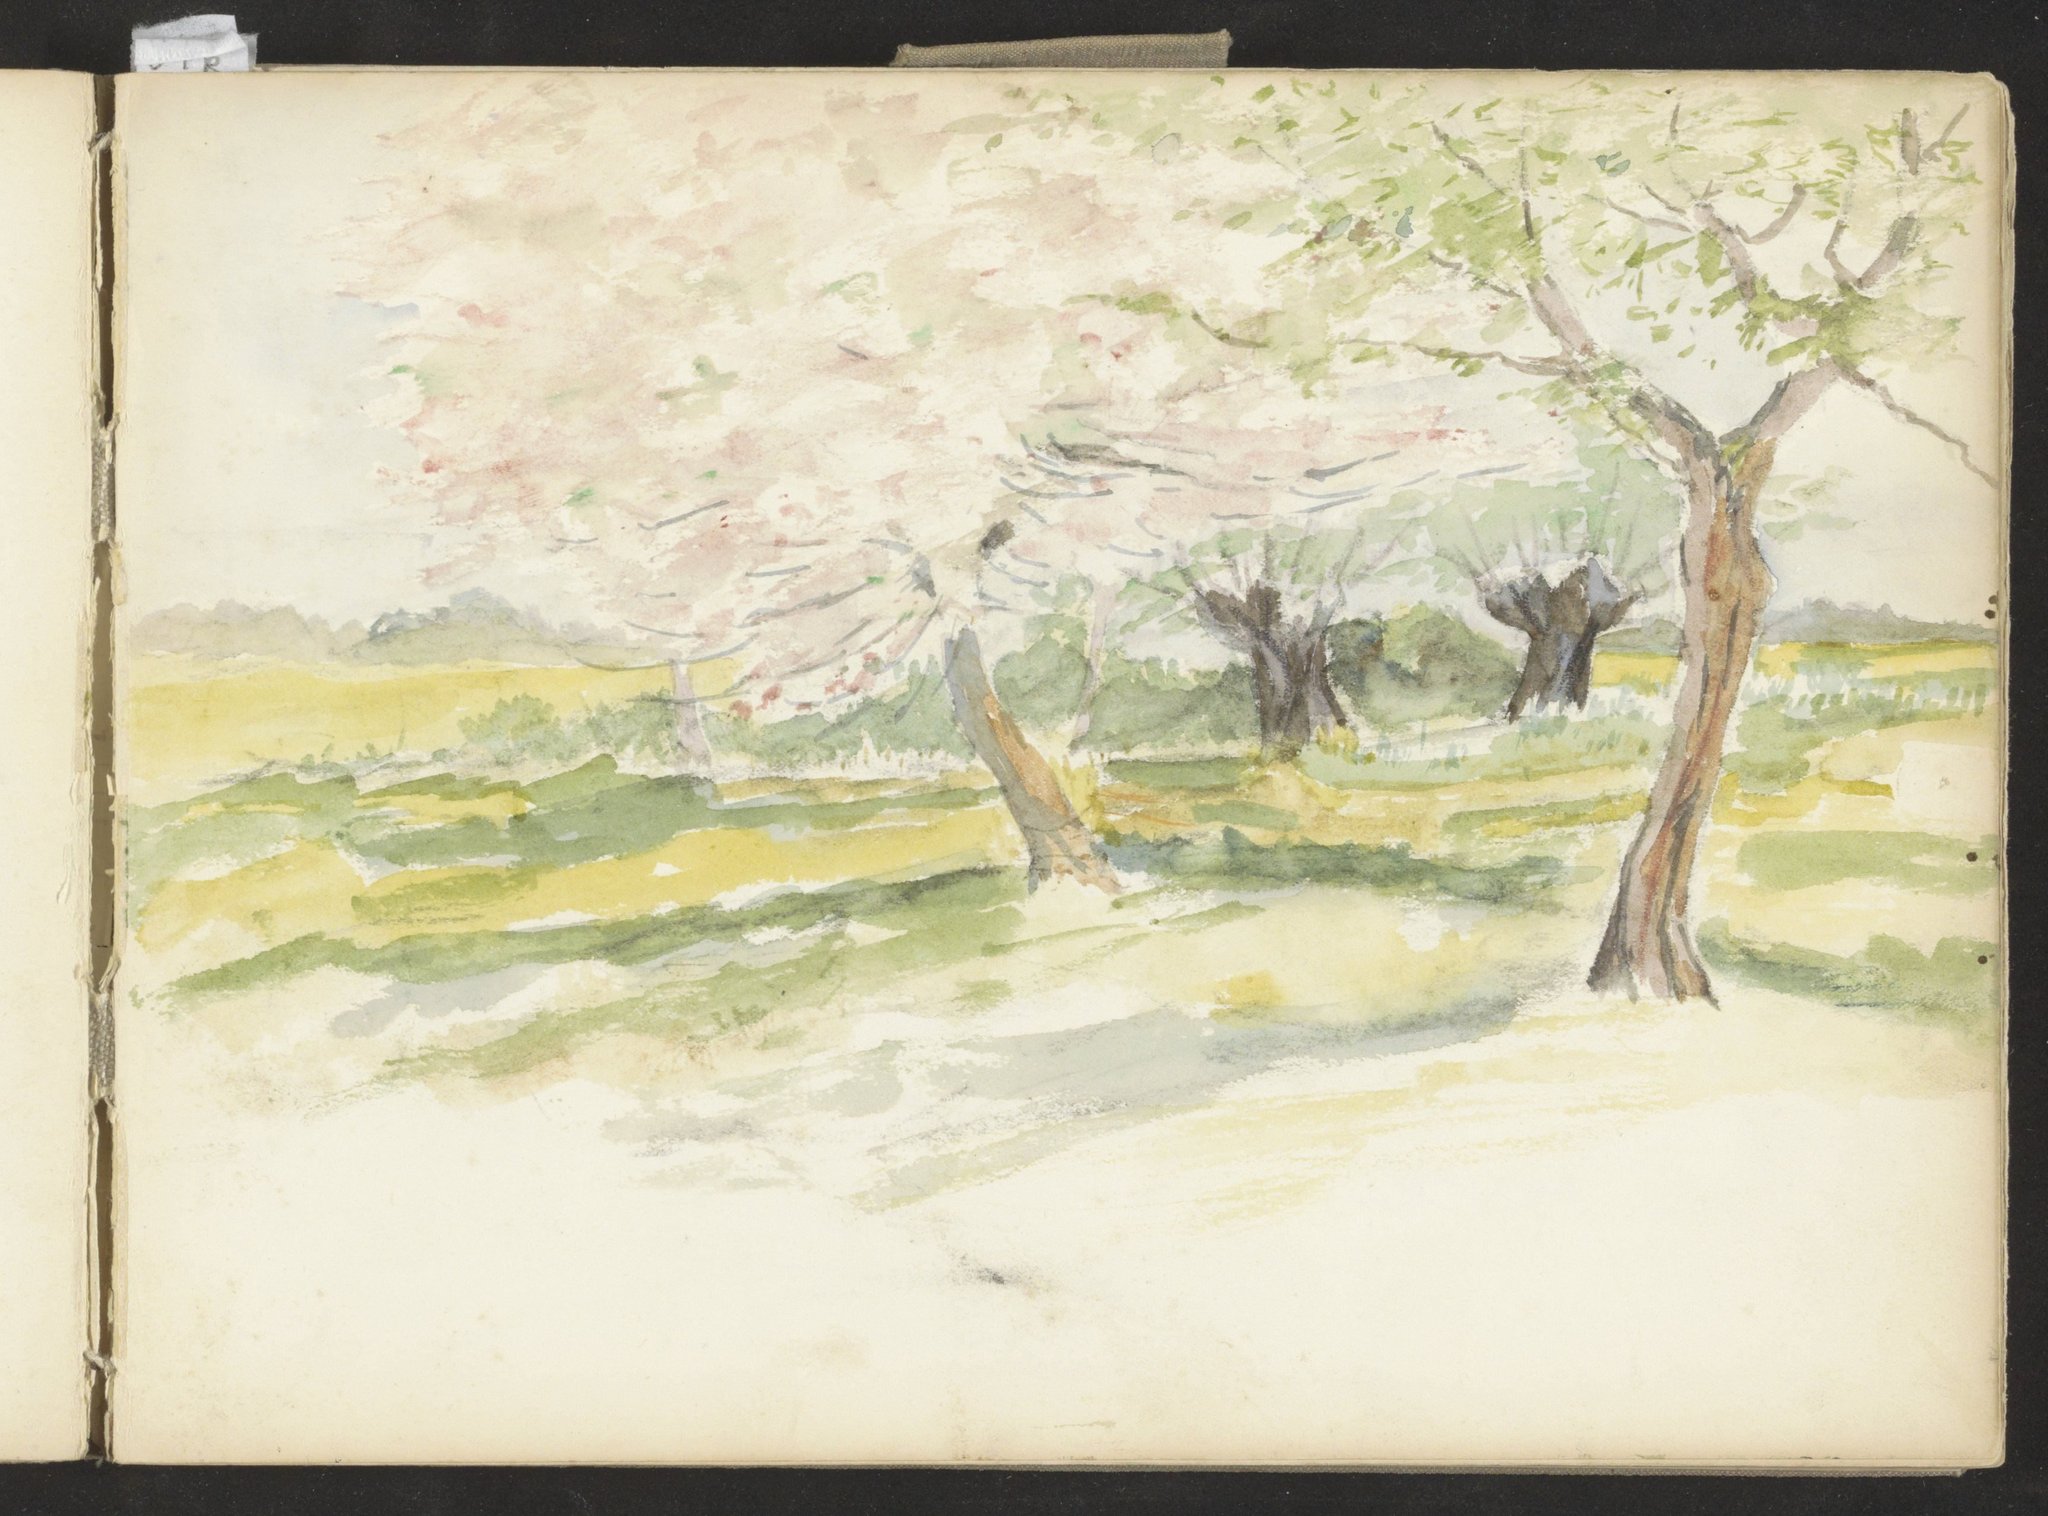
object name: sketchbook leaf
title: Landschap met bomen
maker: jonkheer johannes ludovicus paulus bosch van drakestein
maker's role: draughtsman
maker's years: 1865-1929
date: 1913-1916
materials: paper, pencil, watercolor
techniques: brush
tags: trees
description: Blad 4 recto uit een schetsboek met 47 bladen.